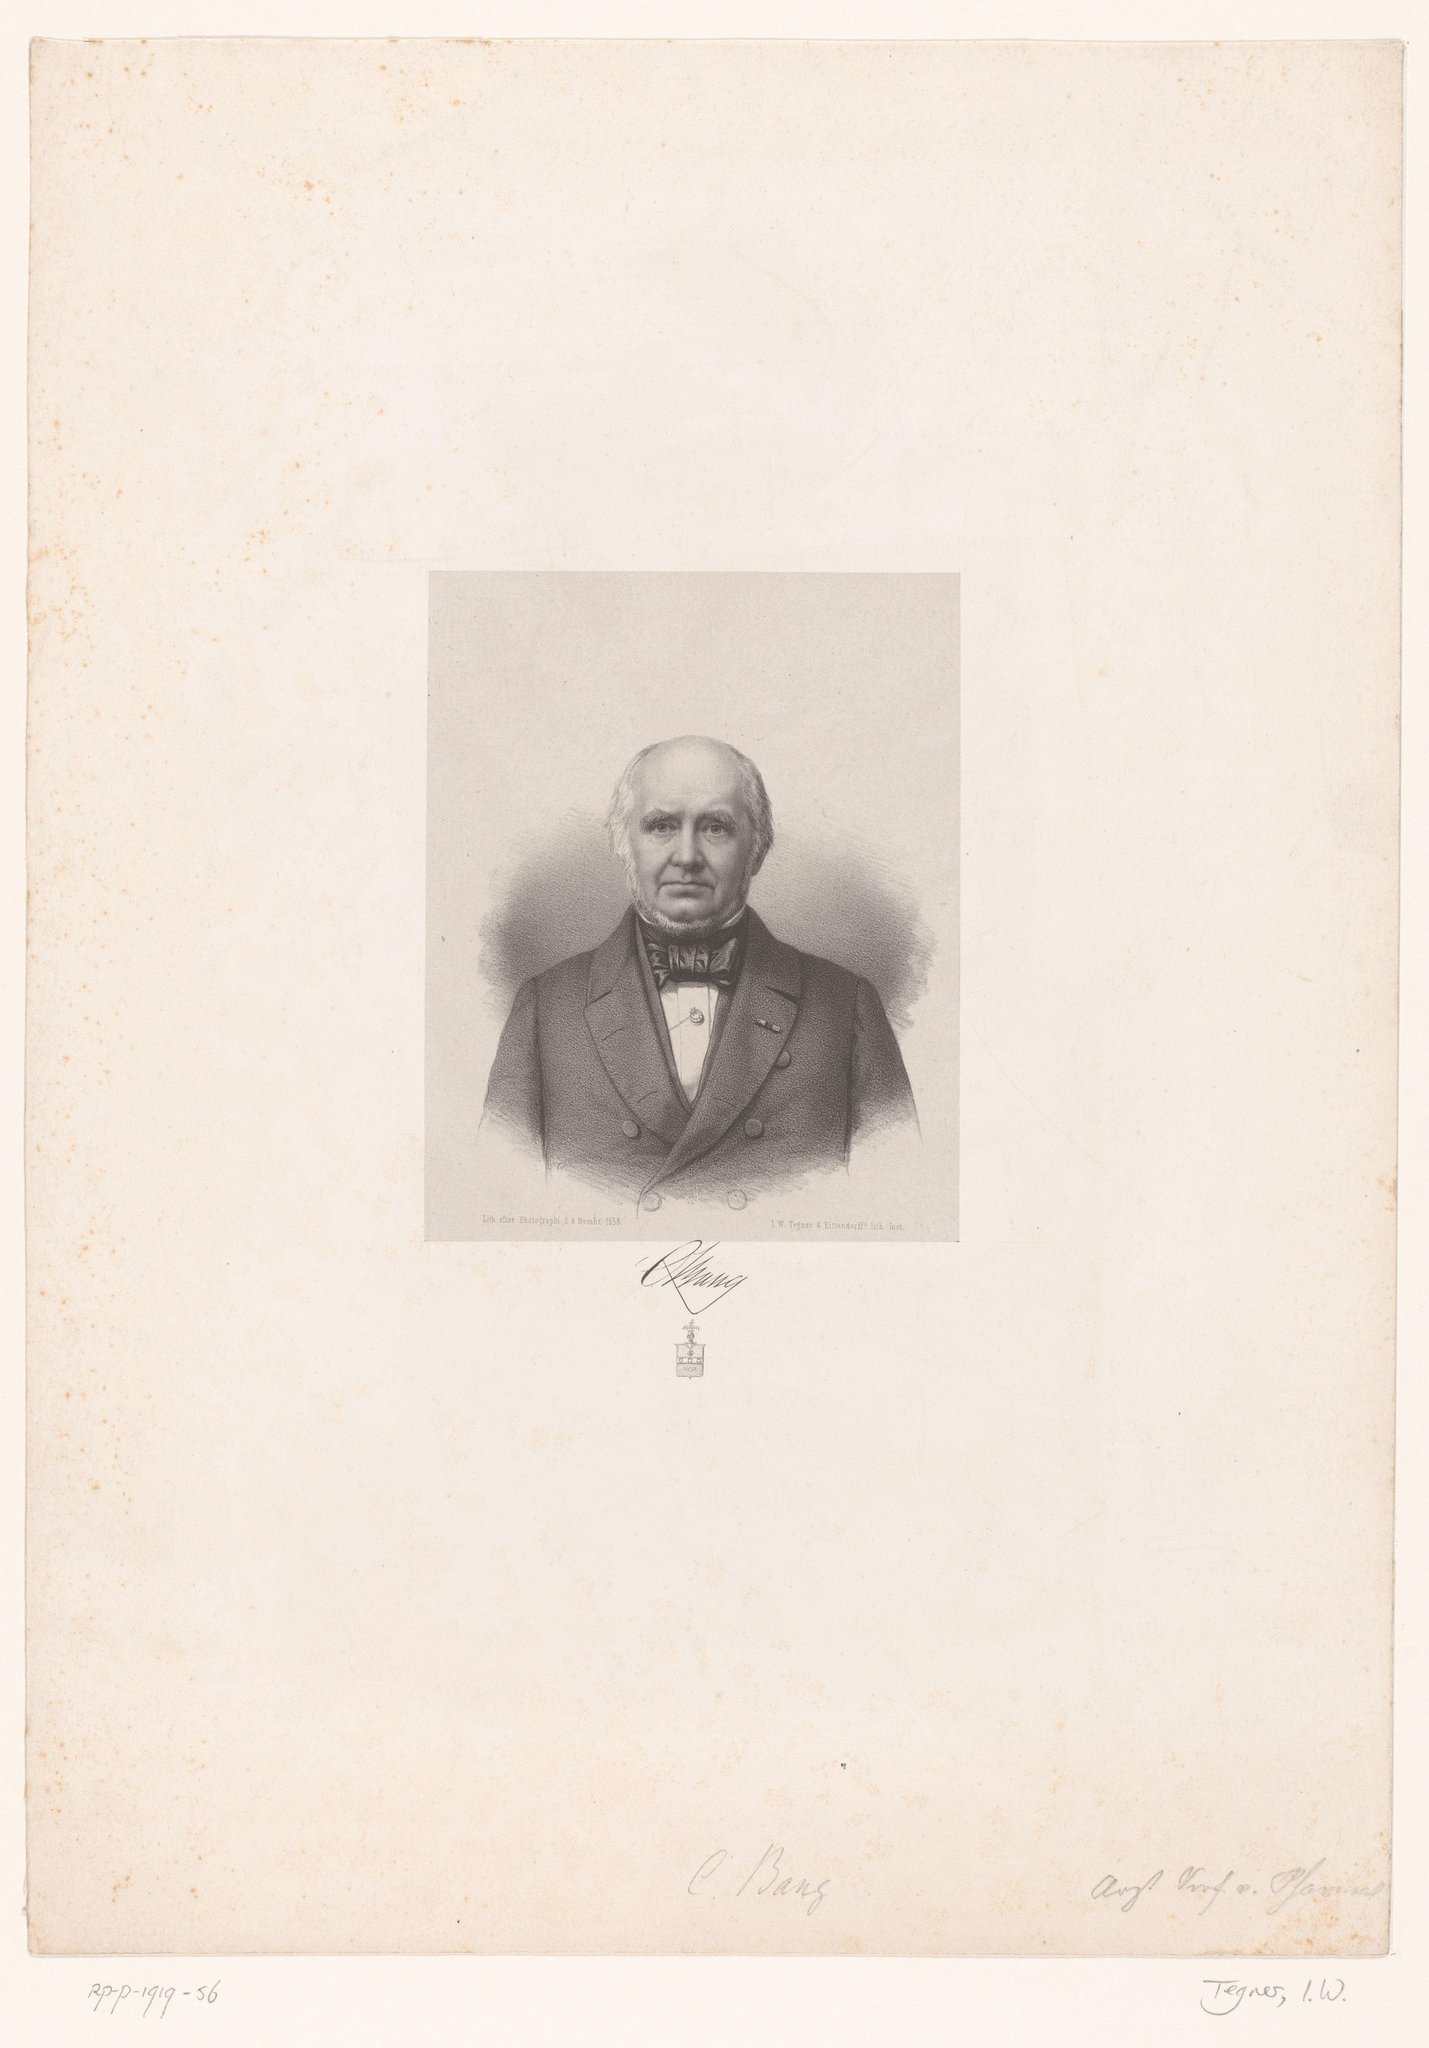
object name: print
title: Portret van een onbekende man, mogelijk C. Bang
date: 1850-1893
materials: paper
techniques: lithograph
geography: denmark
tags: historical persons not known by name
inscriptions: collector's mark: Lugt 2228, coat of arms: ‘Schild met helm van een harnas erboven, in drie delen opgedeeld: een bloem, drie sterren en een liggend maantje.’, inscription: ‘CMang (?)’, signature: ‘J.W. Tegner & Kittendorff lith.Inst.’, inscription: ‘Lith. efter Photograph d. 4 Nvmbr. 1858.’